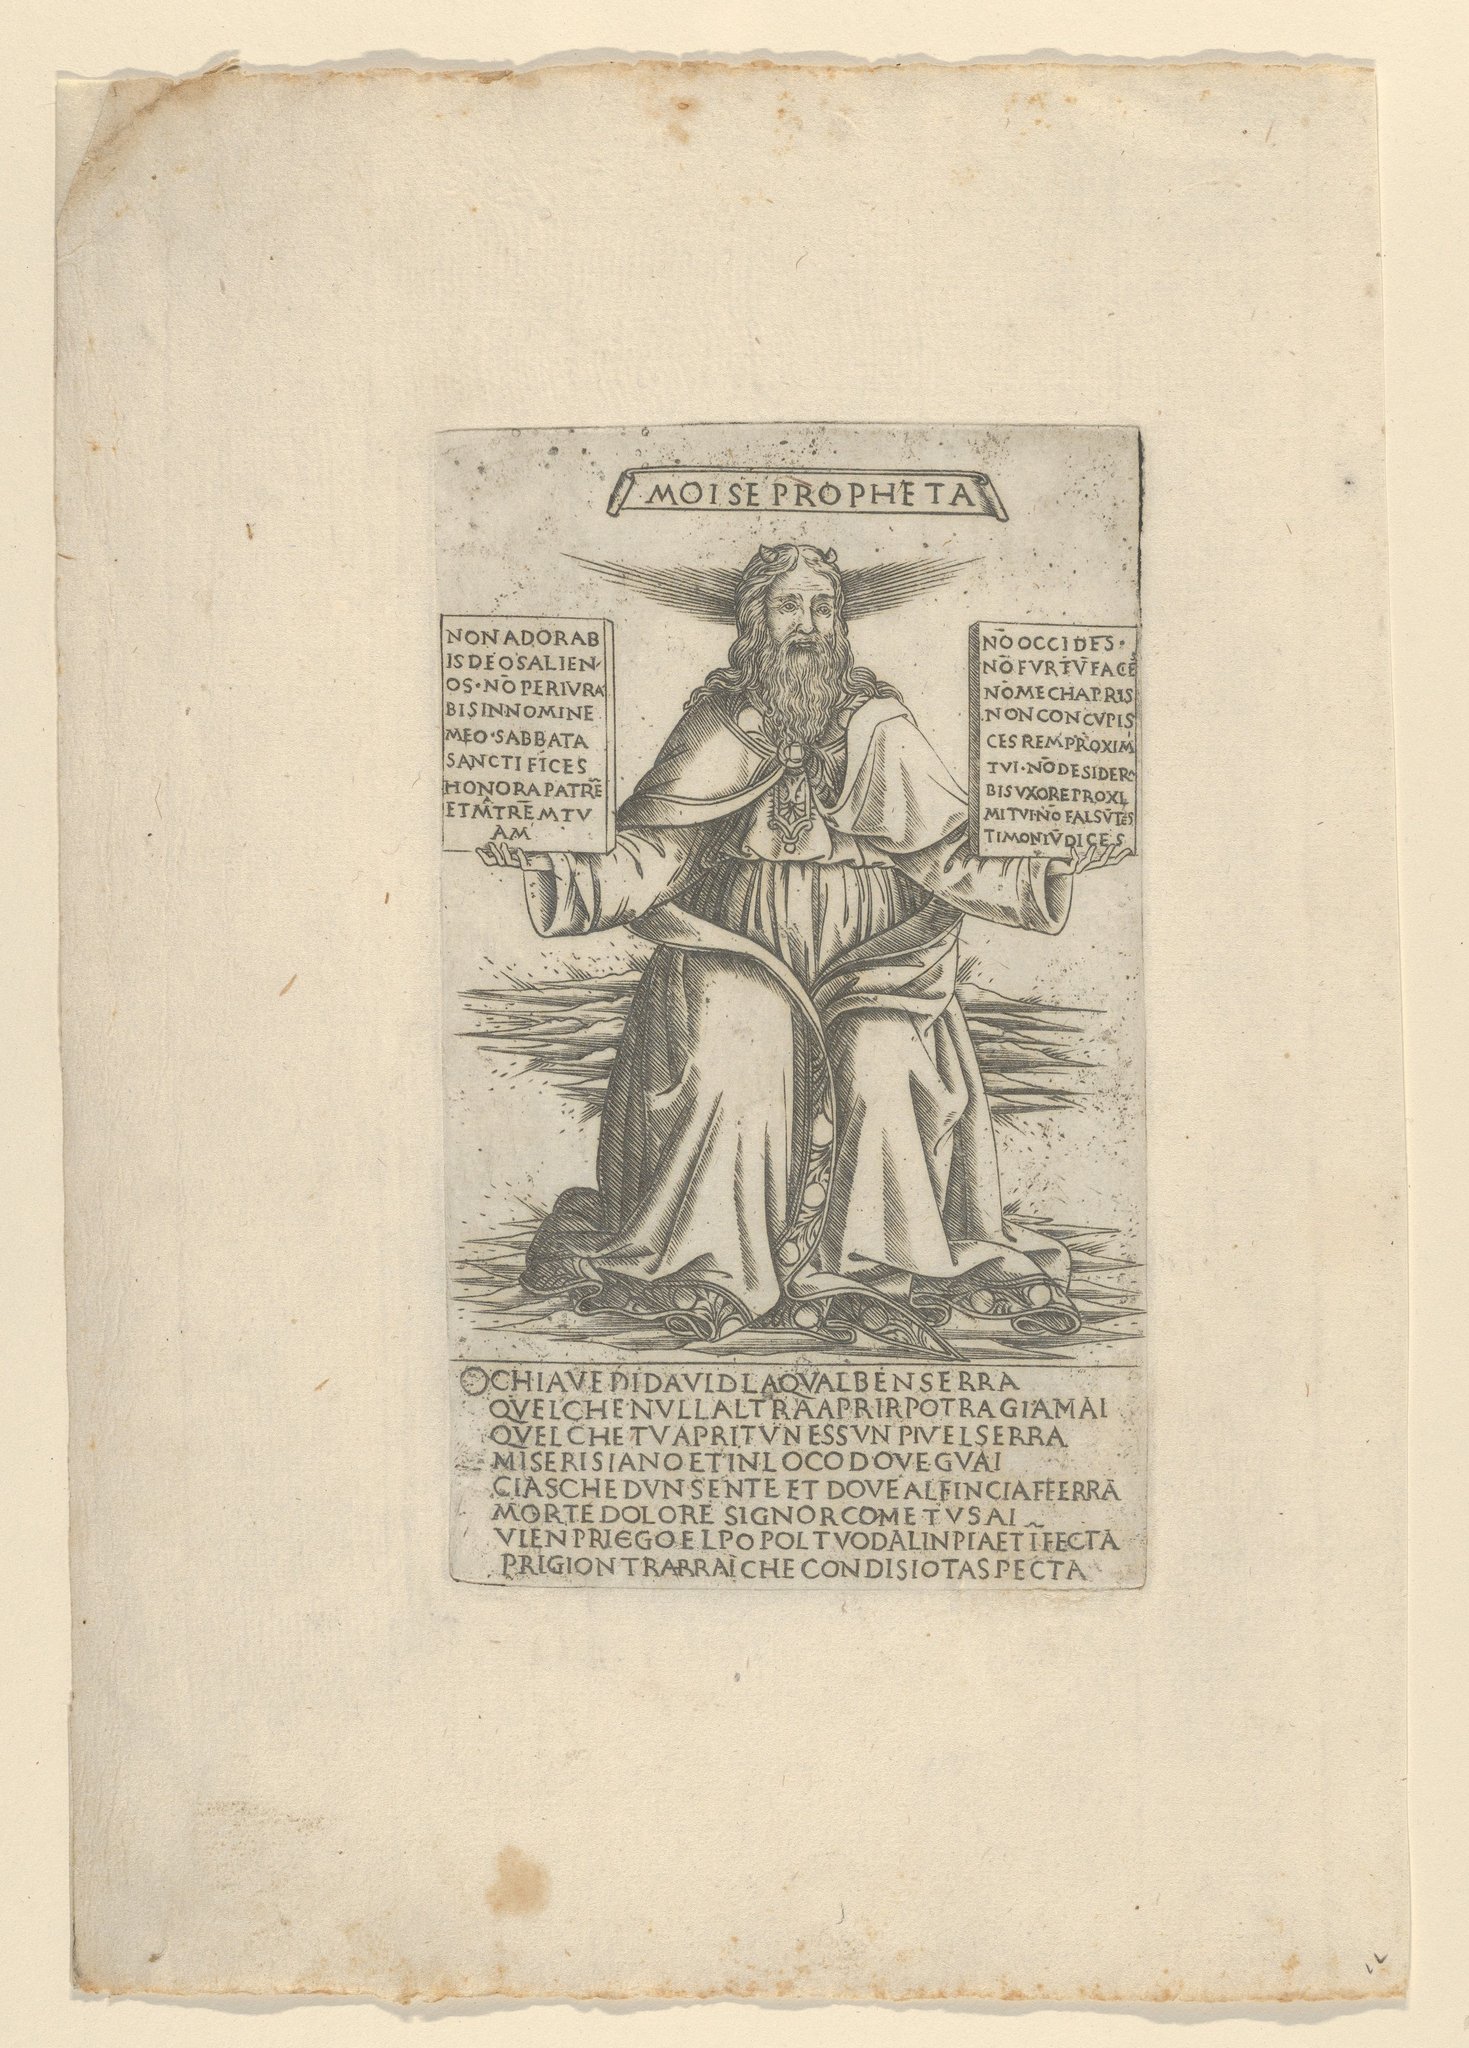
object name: print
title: The Prophet Moses, from Prophets and Sibyls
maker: francesco rosselli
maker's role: artist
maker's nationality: italian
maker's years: 1448-1527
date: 1480-1490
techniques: engraving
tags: moses